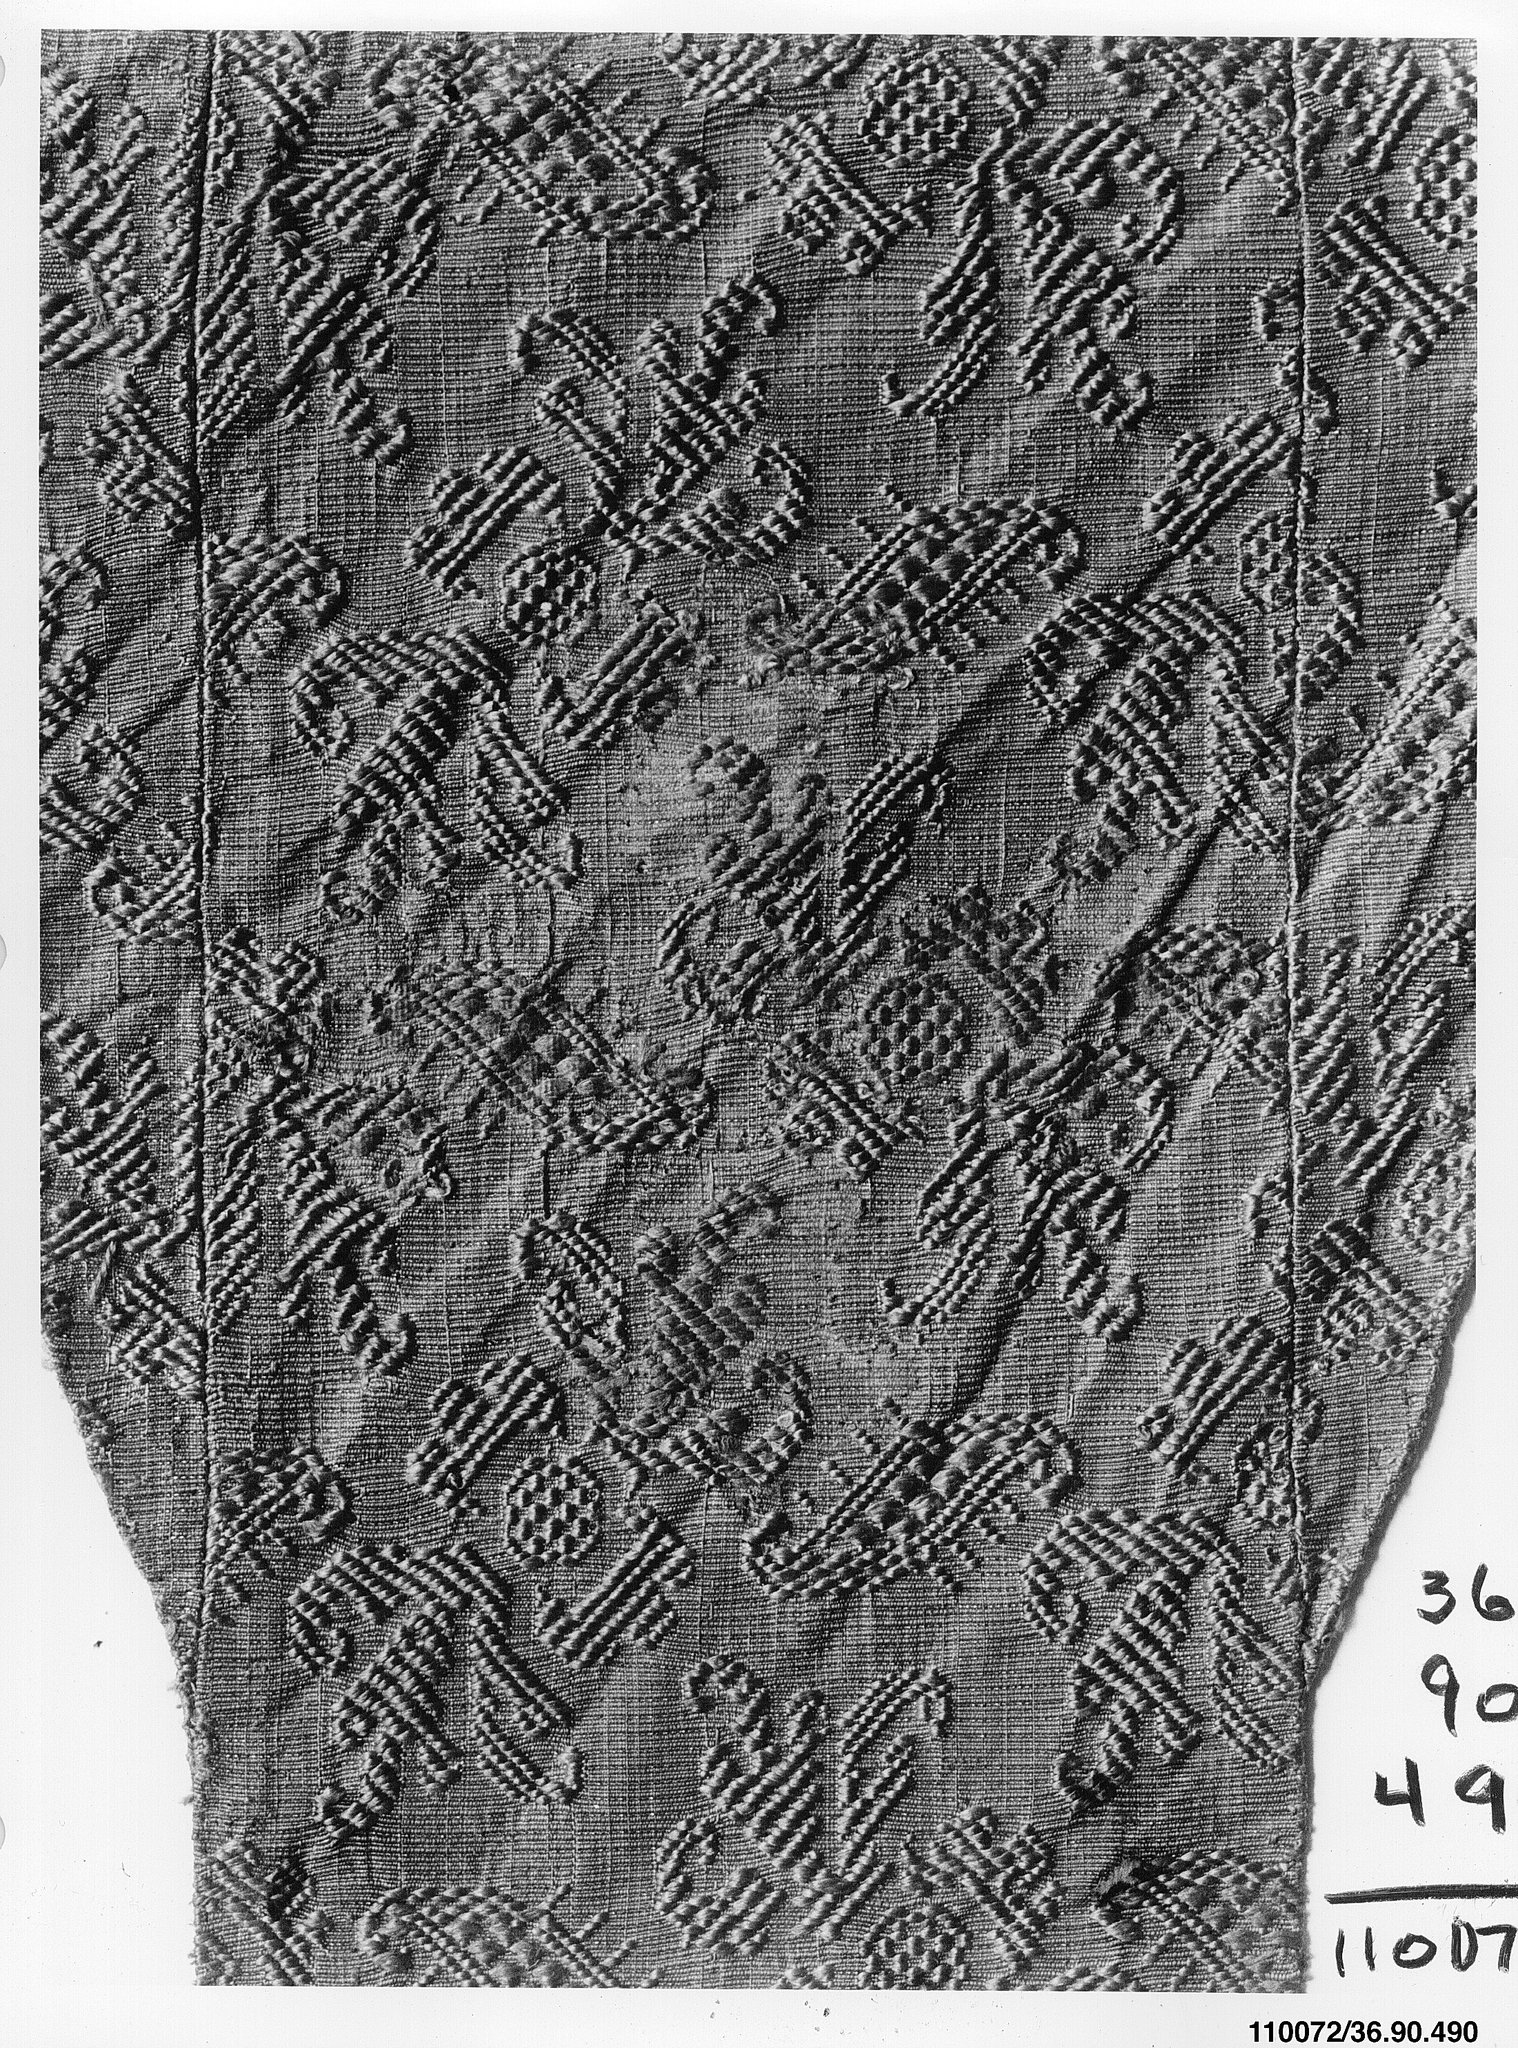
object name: piece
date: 1501-1700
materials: metal thread, silk